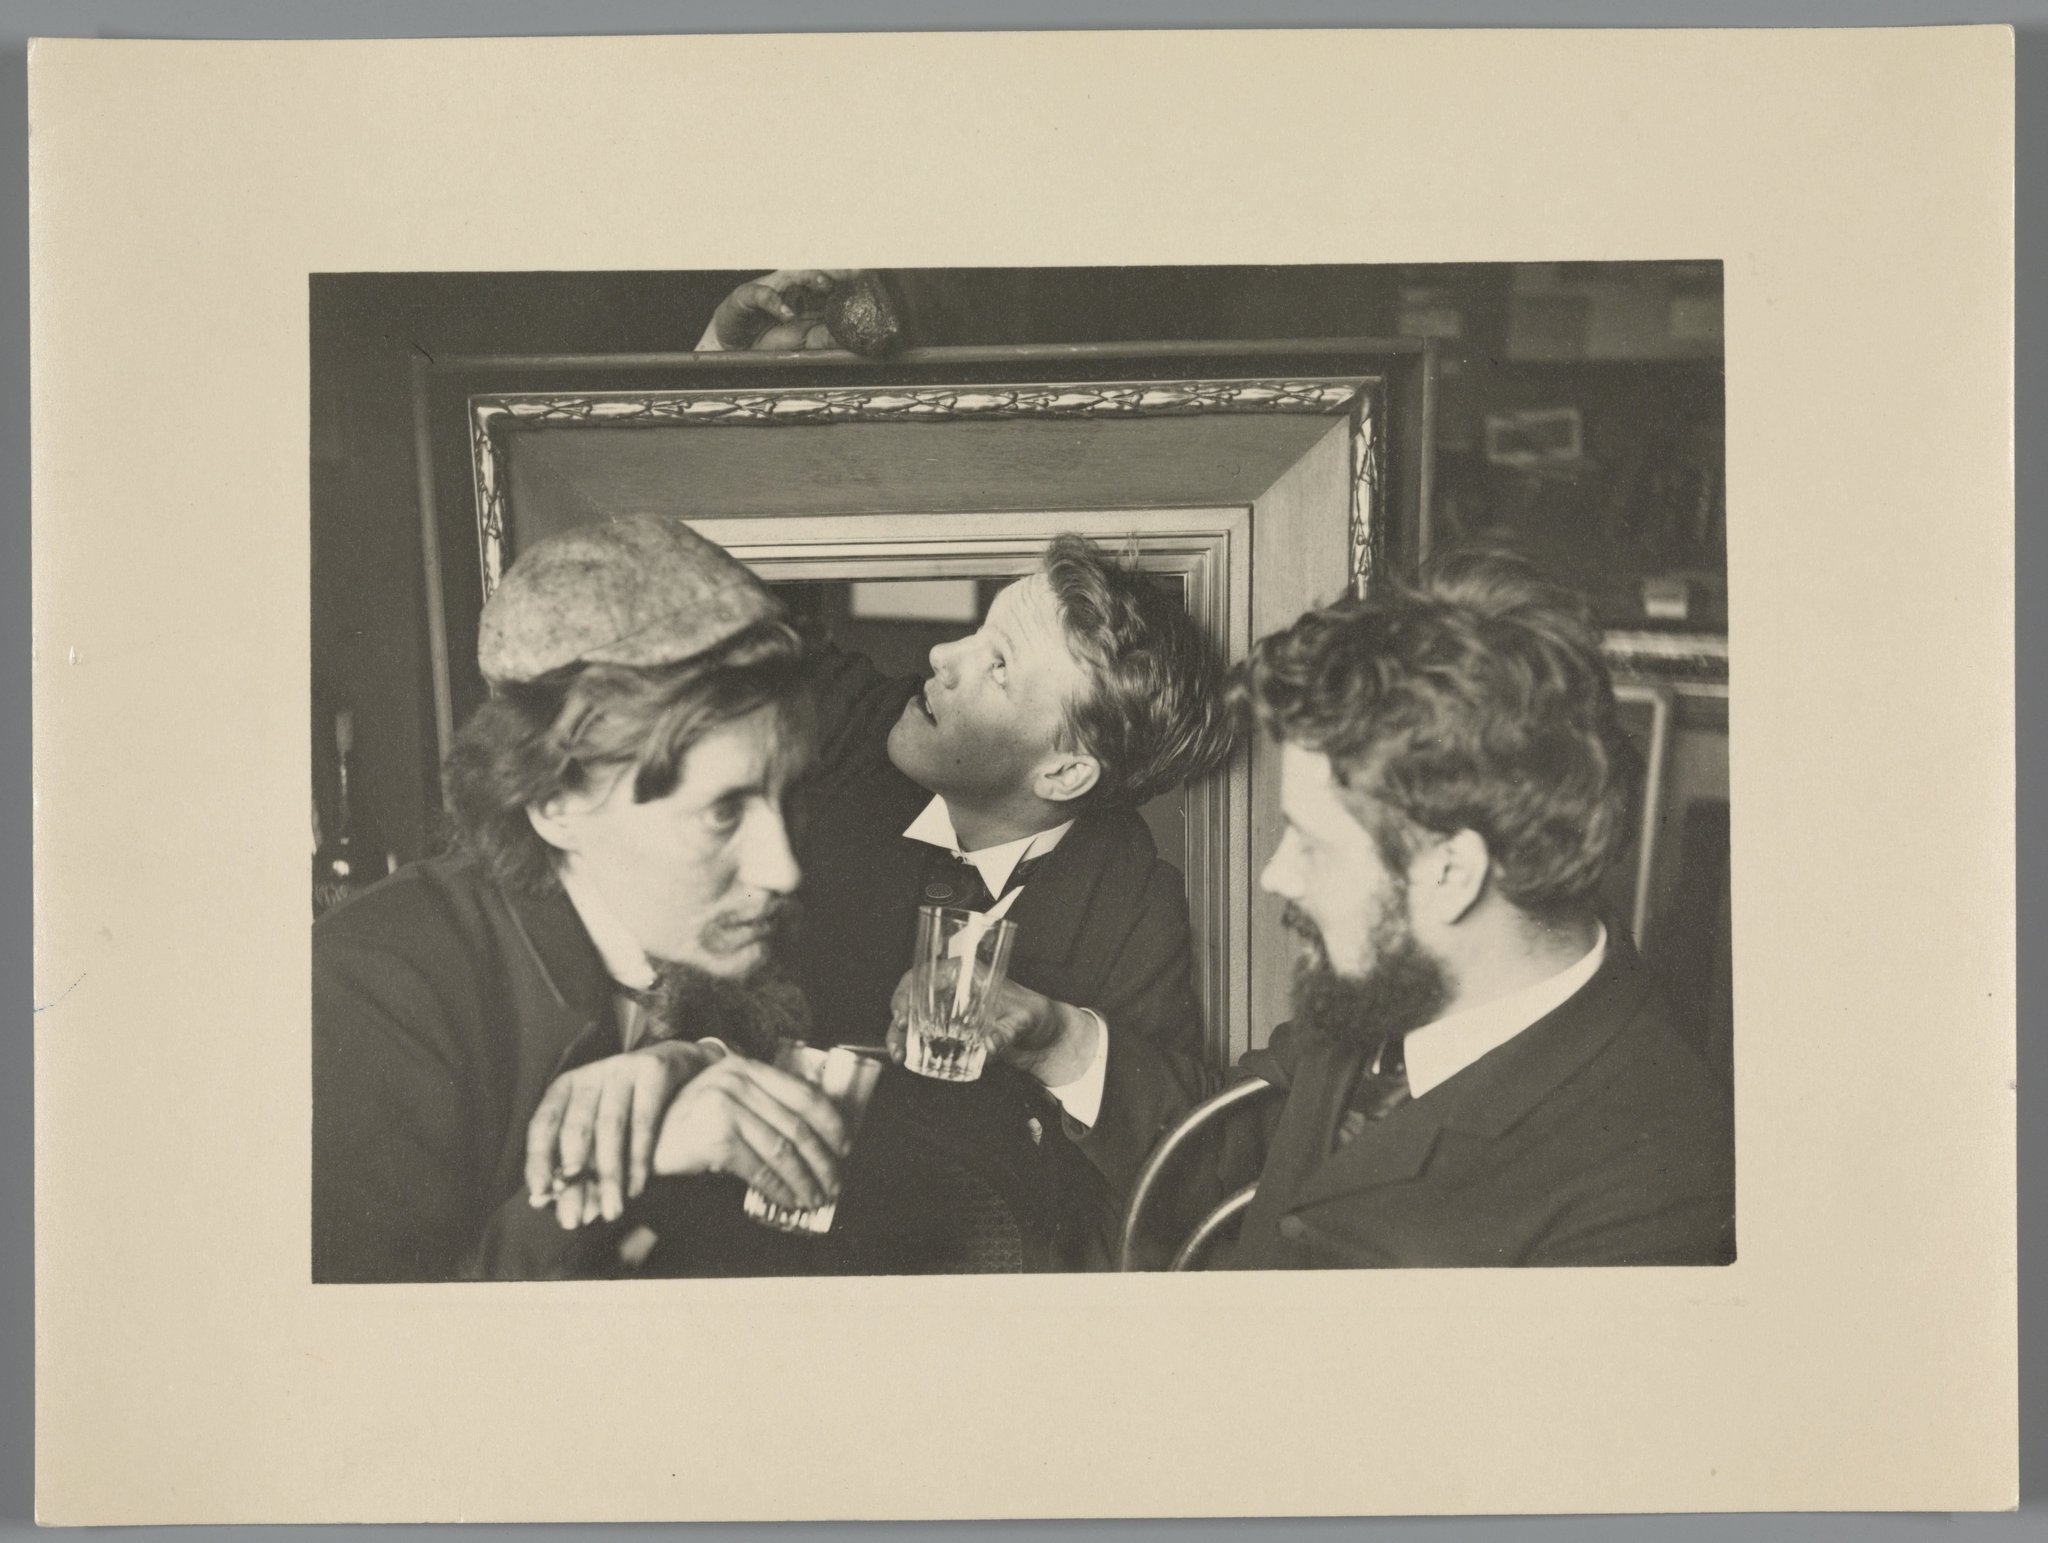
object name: photograph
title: Reproductie naar een foto van Willem Witsen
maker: Anonymous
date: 1860-1915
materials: paper, photographic support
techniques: gelatin silver print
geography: netherlands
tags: amsterdam, the hague, willem kloos